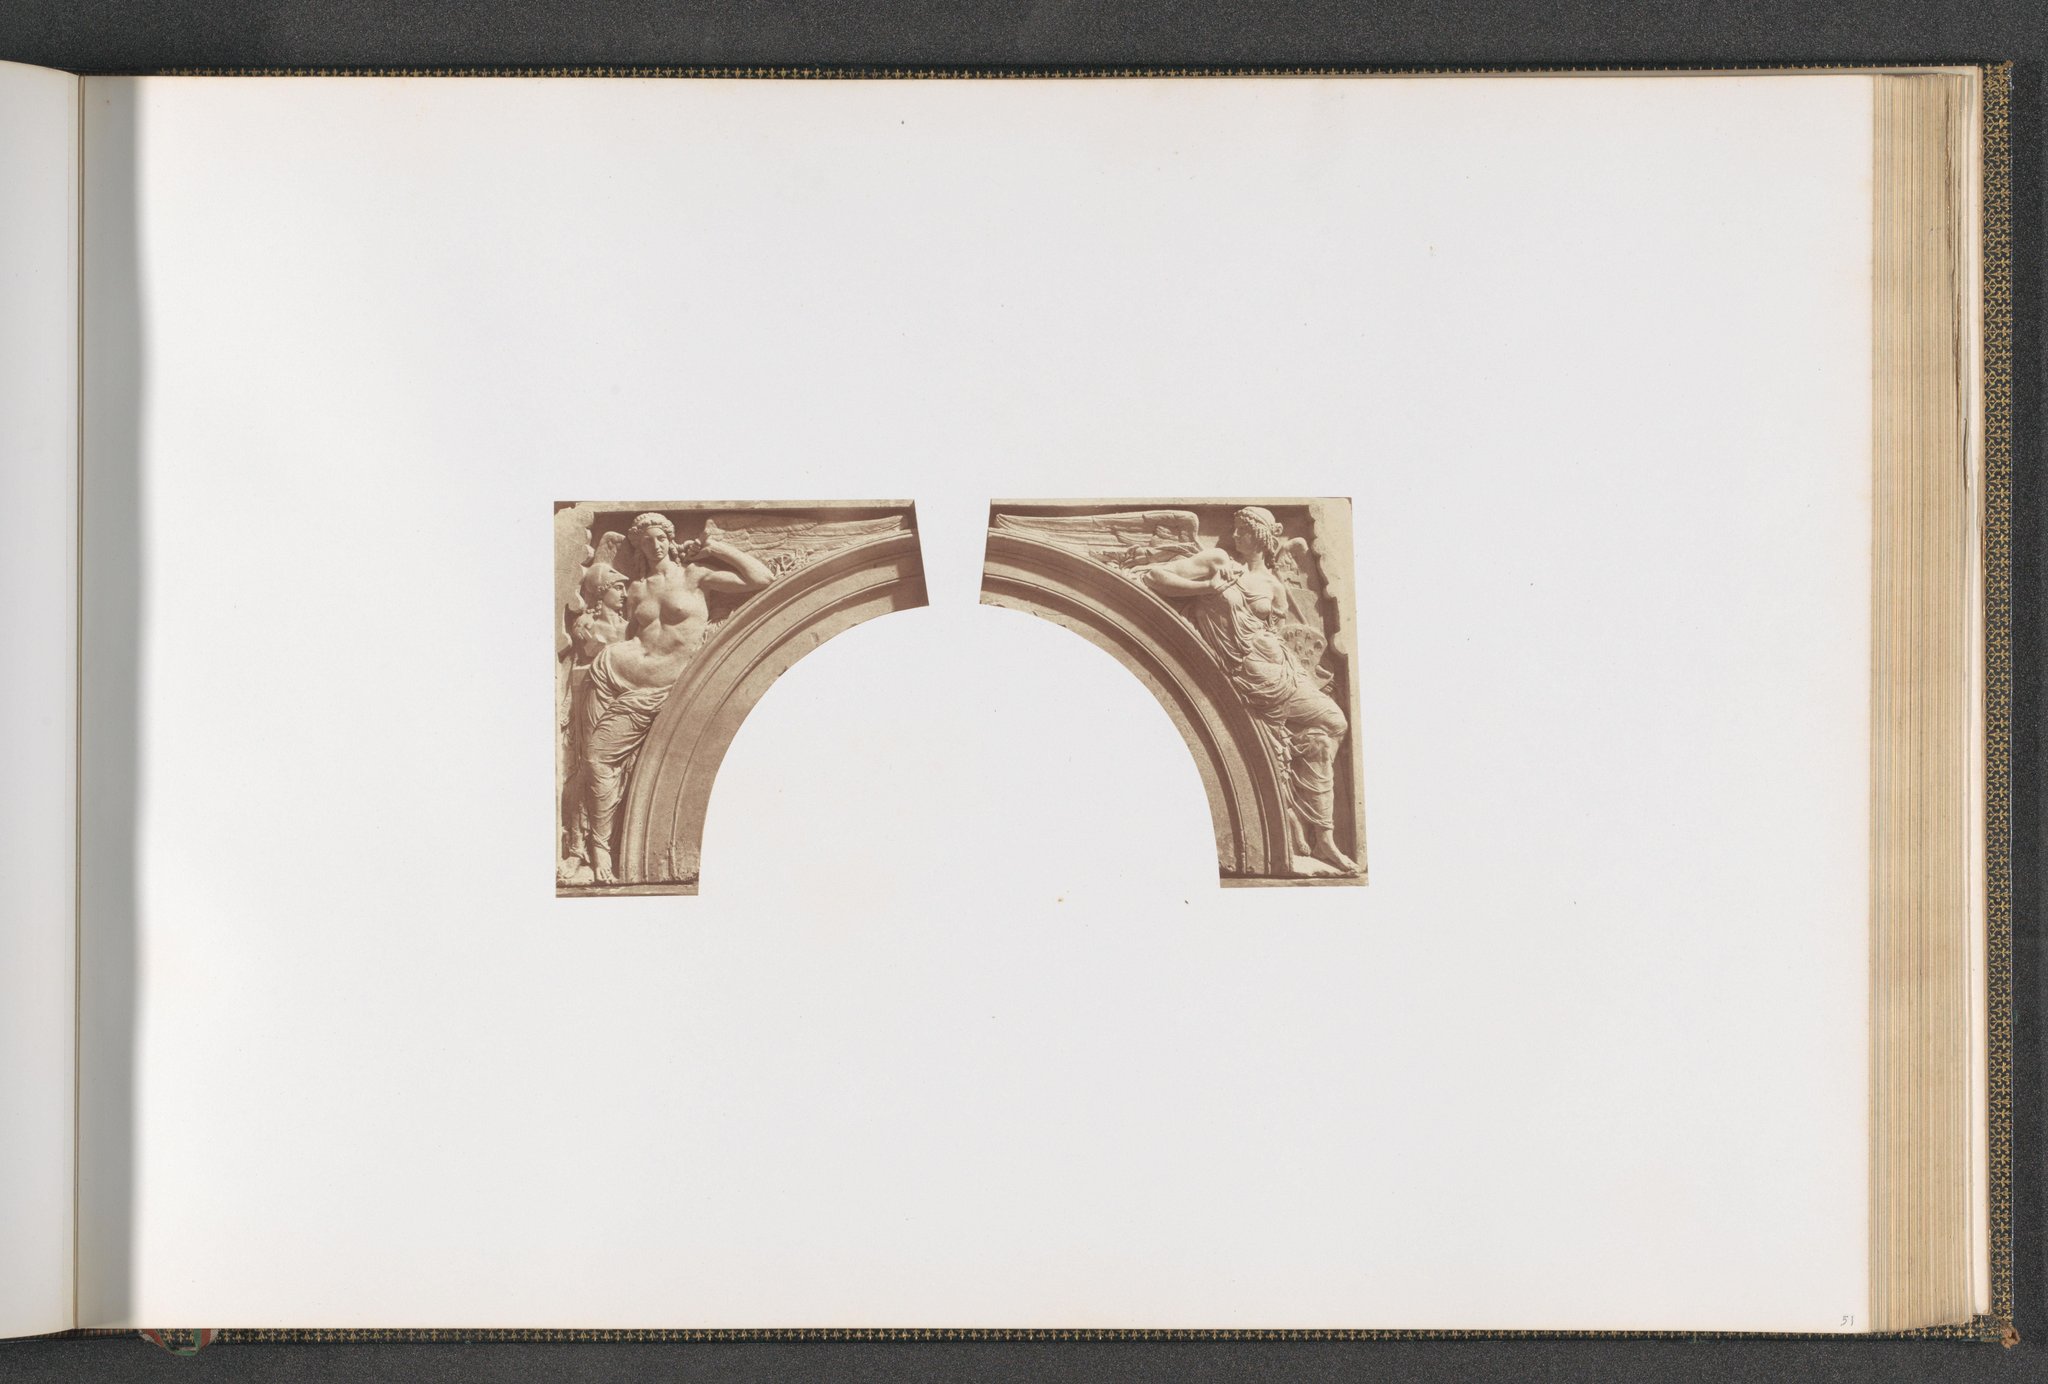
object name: photograph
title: Gipsmodellen voor beeldhouwwerken op het Palais du Louvre: links "La Sculpture" en rechts "La Peinture" door François Félix Roubaud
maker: édouard denis baldus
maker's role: fotograaf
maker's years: 1813-1889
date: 1855-1857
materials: paper, photographic support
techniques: salted paper print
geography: paris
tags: piece of sculpture, reproduction of a piece of sculpture, permanent exhibition, museum, paris, tuileries palace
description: Onderdeel van Réunion des Tuileries au Louvre 1852-1857, album 2.